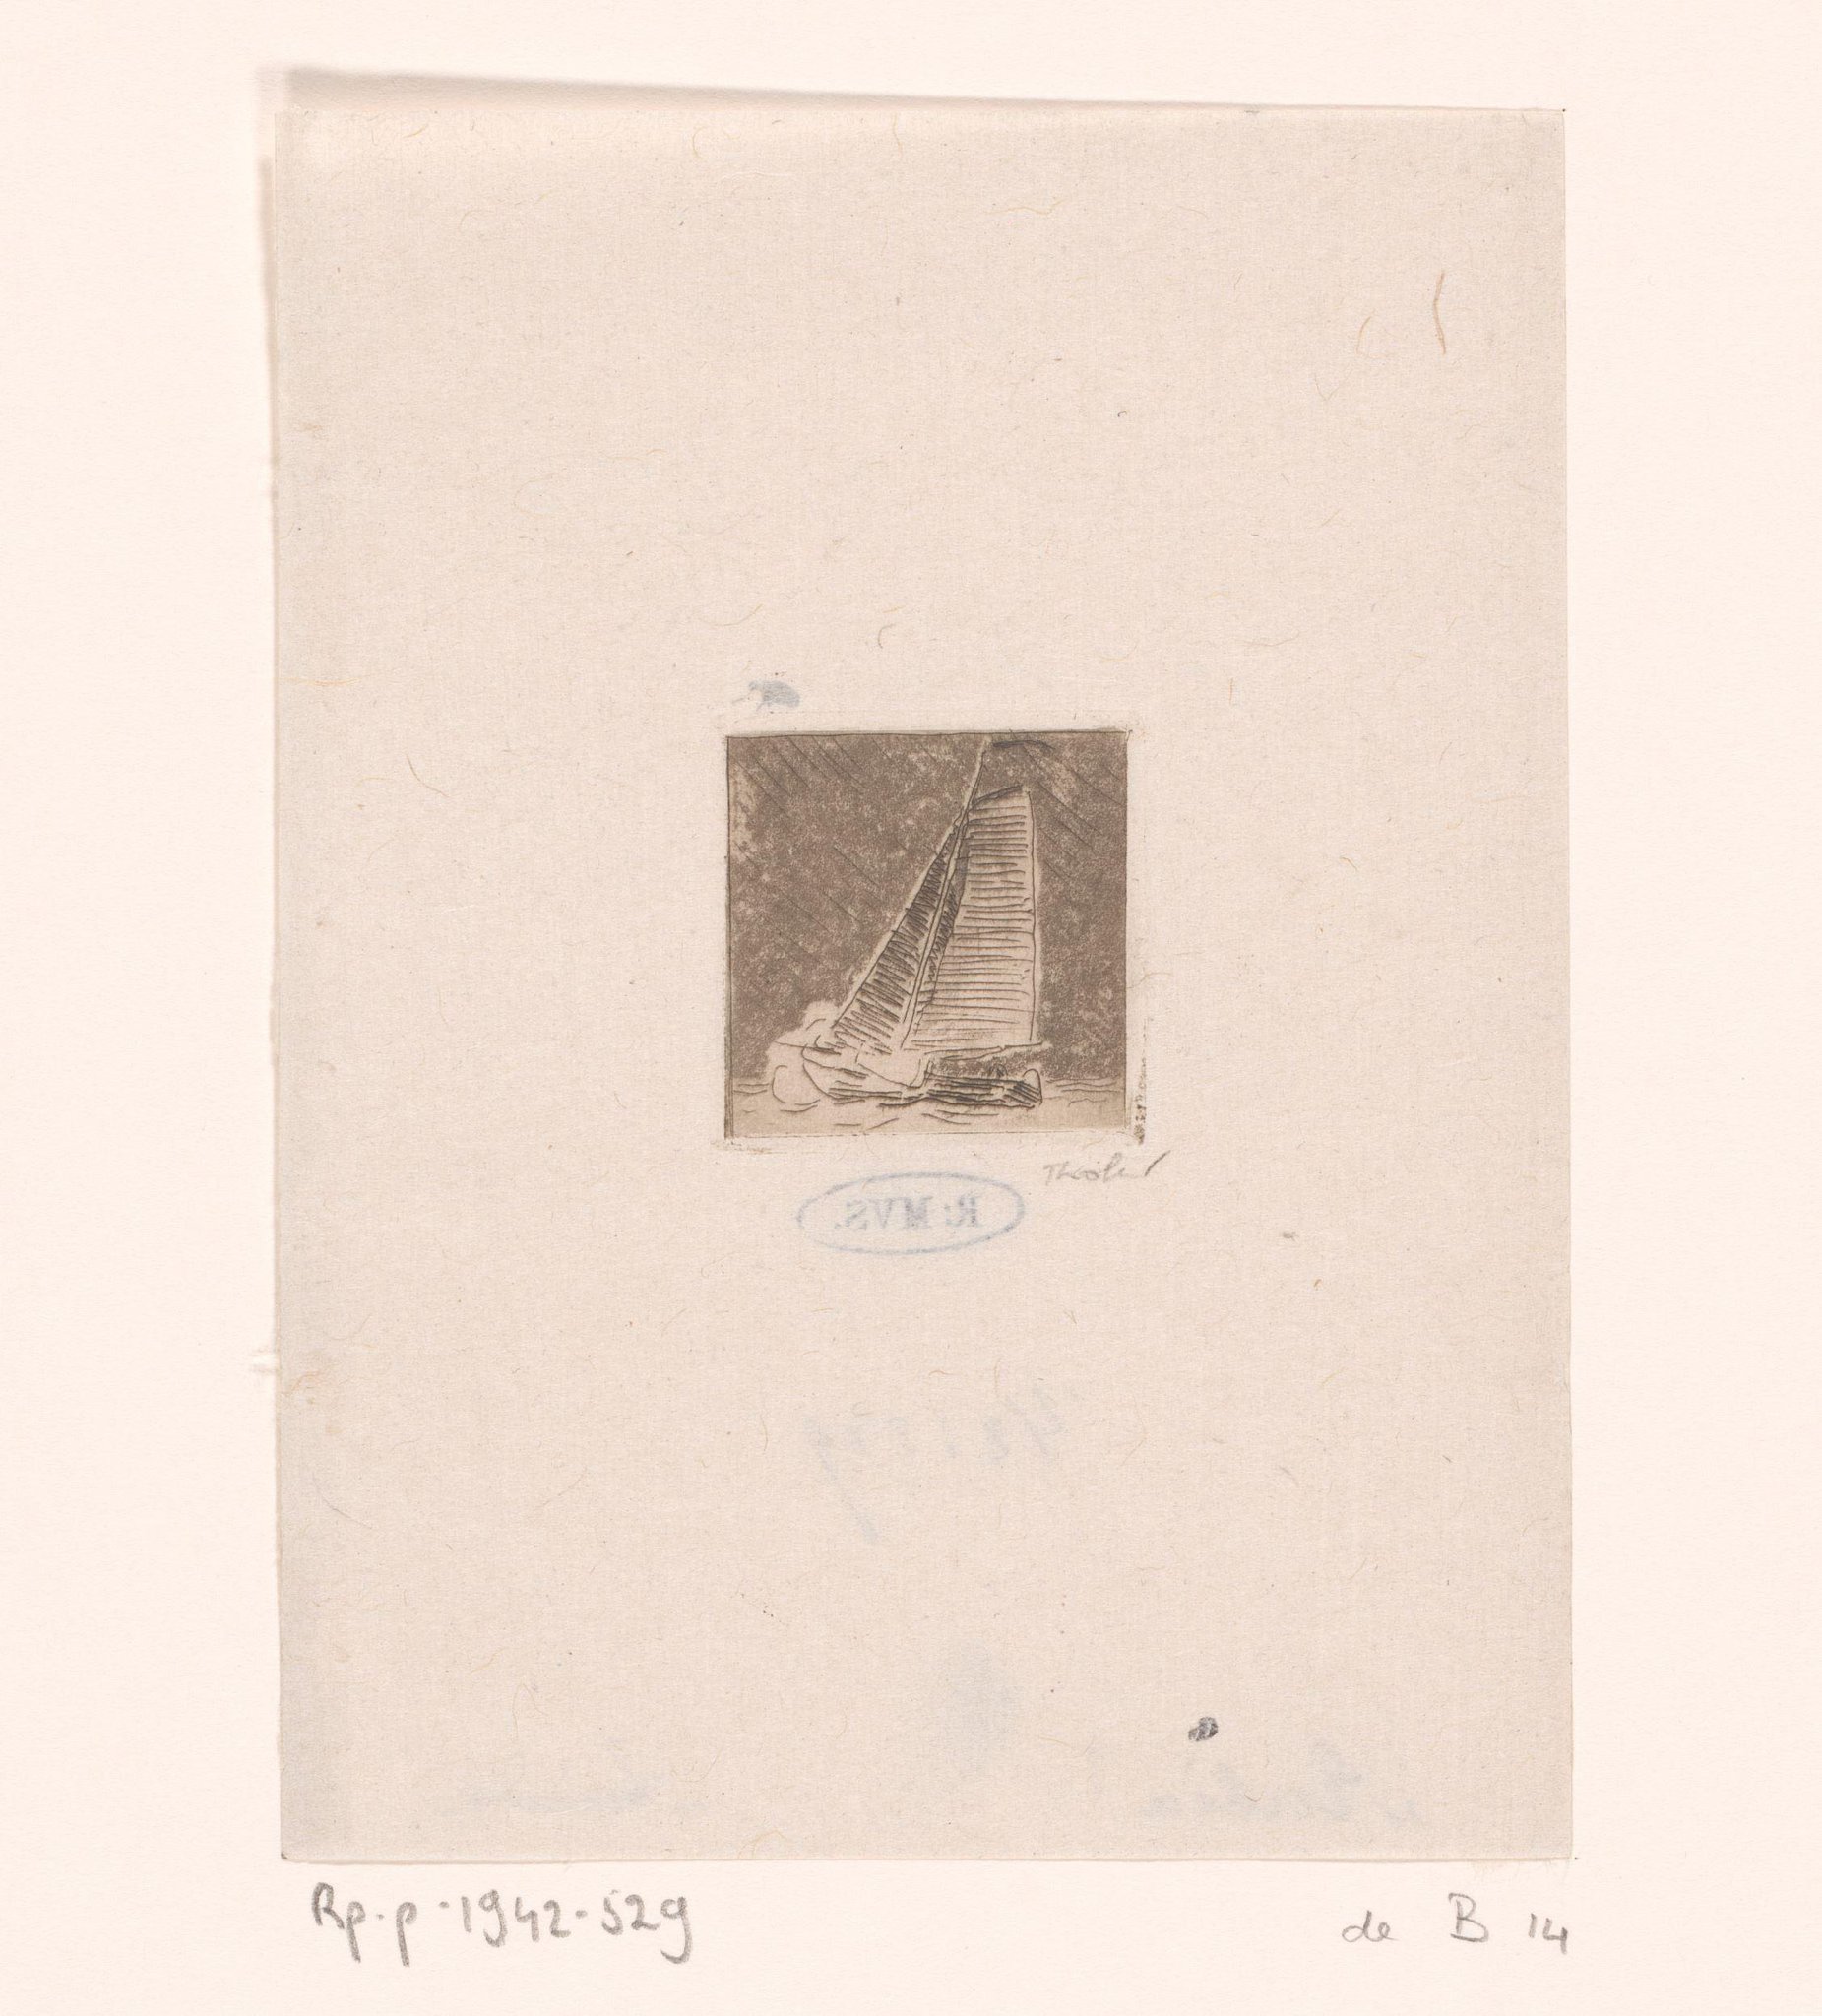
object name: print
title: Zeilende botter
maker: willem bastiaan tholen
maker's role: draughtsman, painter, print maker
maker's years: 1860-1931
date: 1870-1931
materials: paper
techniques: etching, intaglio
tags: sailing-ship, sailing-boat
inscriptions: collector's mark: Lugt 2228, inscription: ‘Eubia’